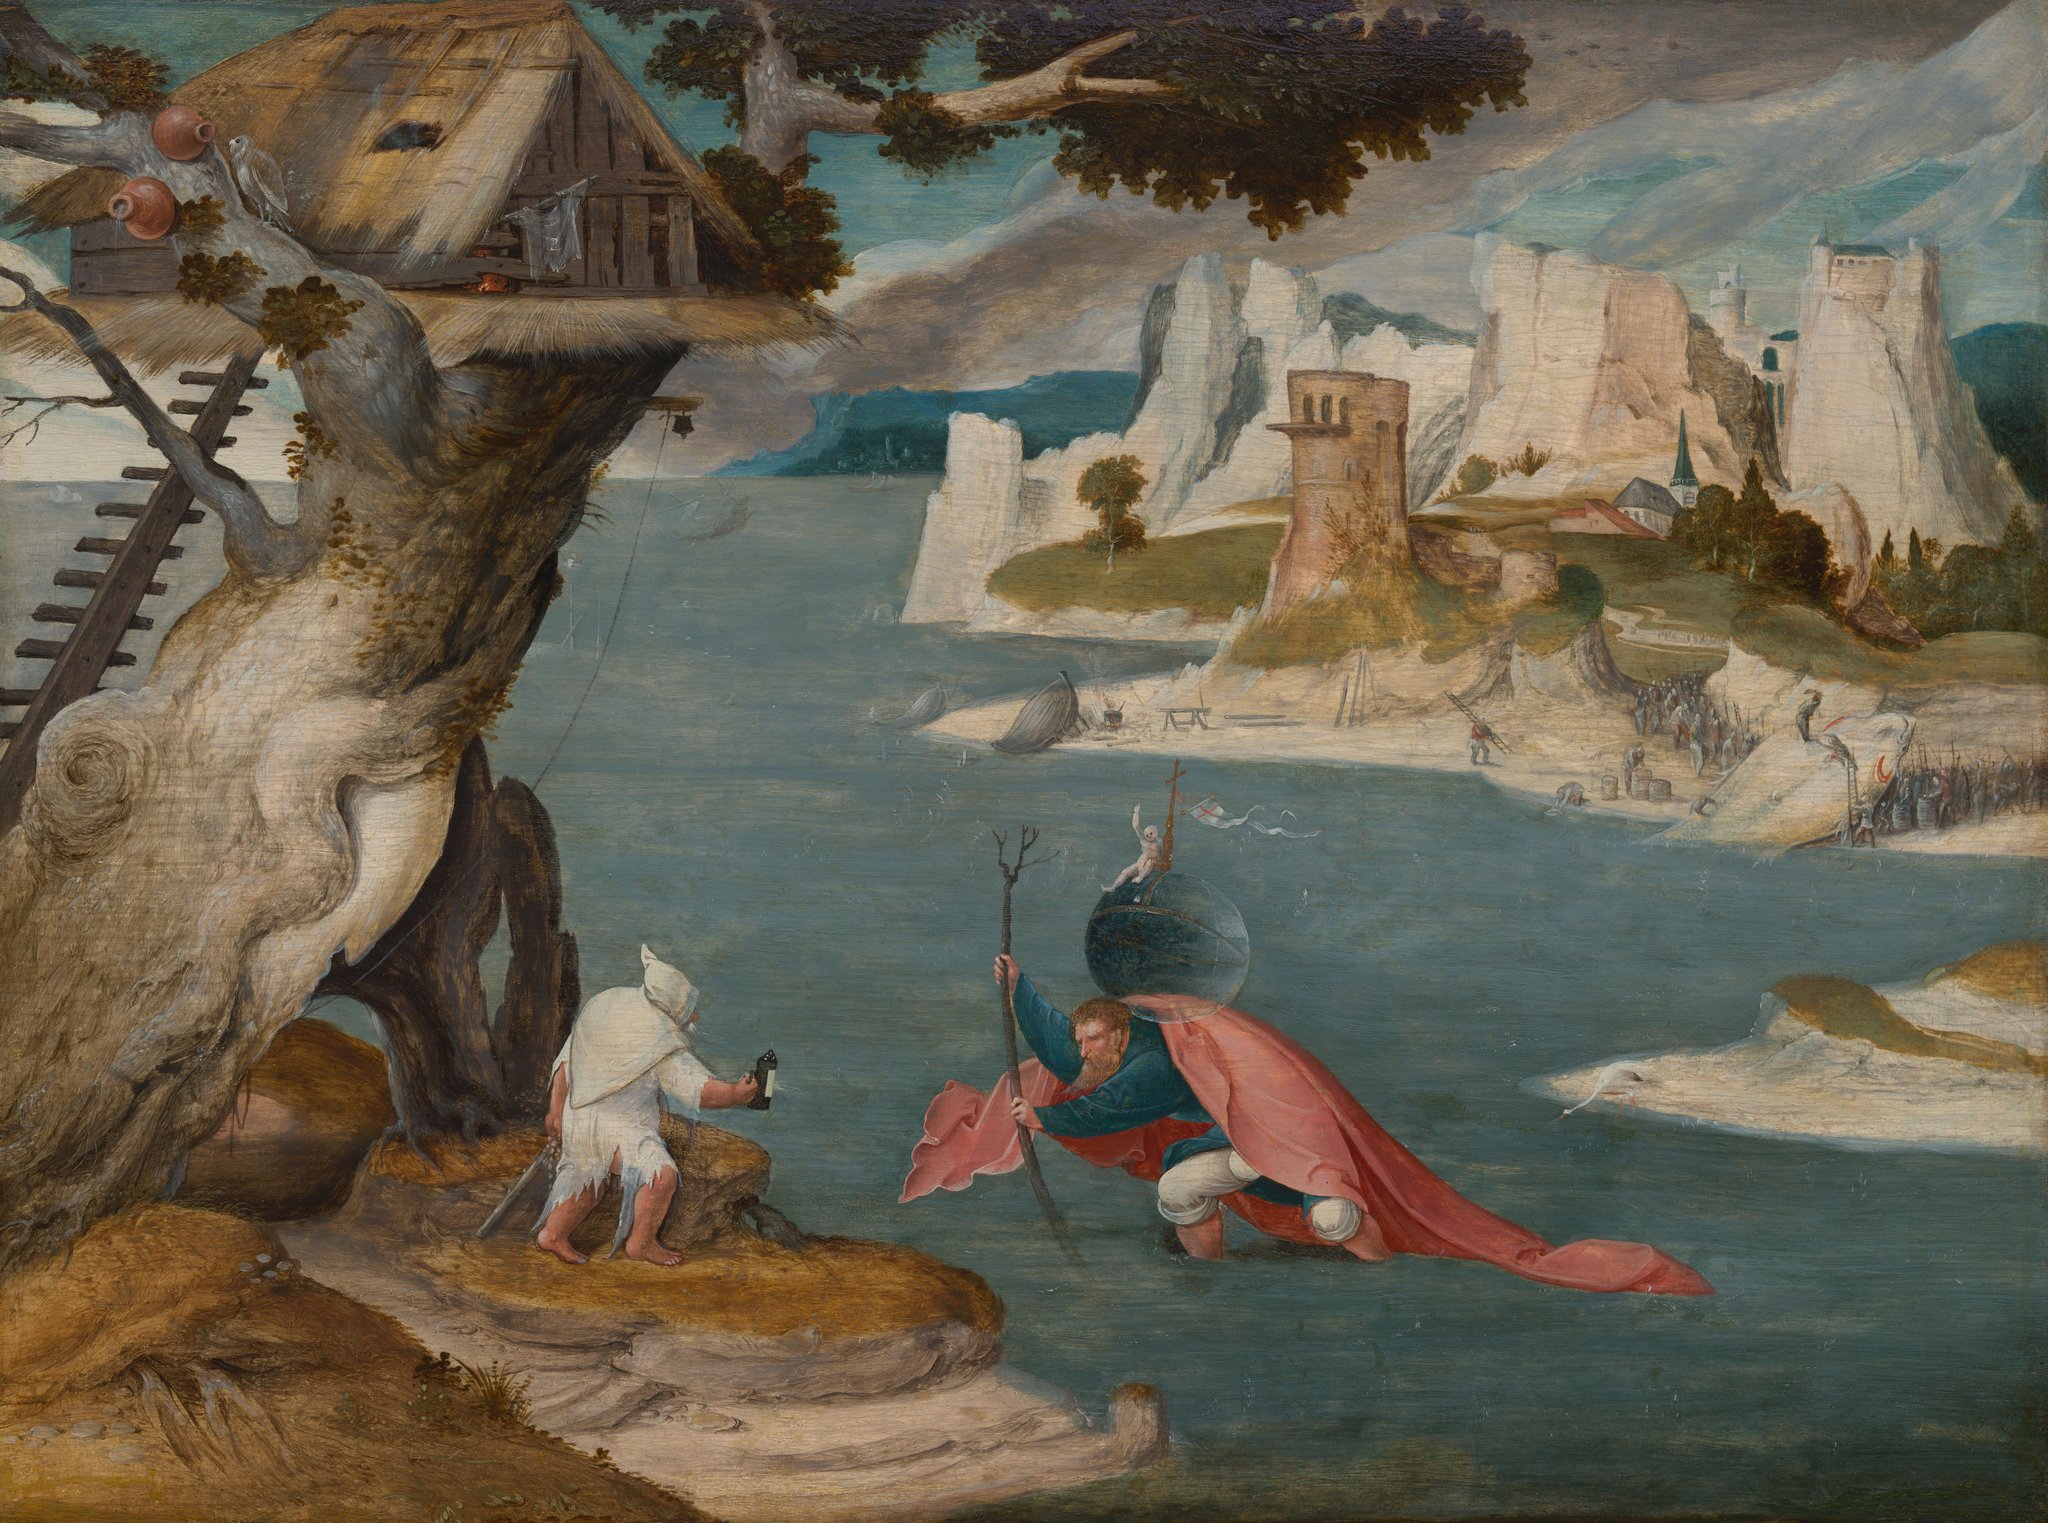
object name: painting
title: Rivierlandschap met de heilige Christoffel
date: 1520-1525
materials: oil, paint, panel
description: Christoffel waadt met behulp van een stok door een rivier. Op zijn rug draagt hij het Christuskind als Salvator Mundi. Het kindje Jezus zit op een rijksappel, bestaande uit een glazen wereldbol en een kruis. Op de oever staat een kluizenaar met een lantaarn onder zijn boomhut. Op de andere rivieroever een nederzetting met op het strand een aangespoelde walvis.